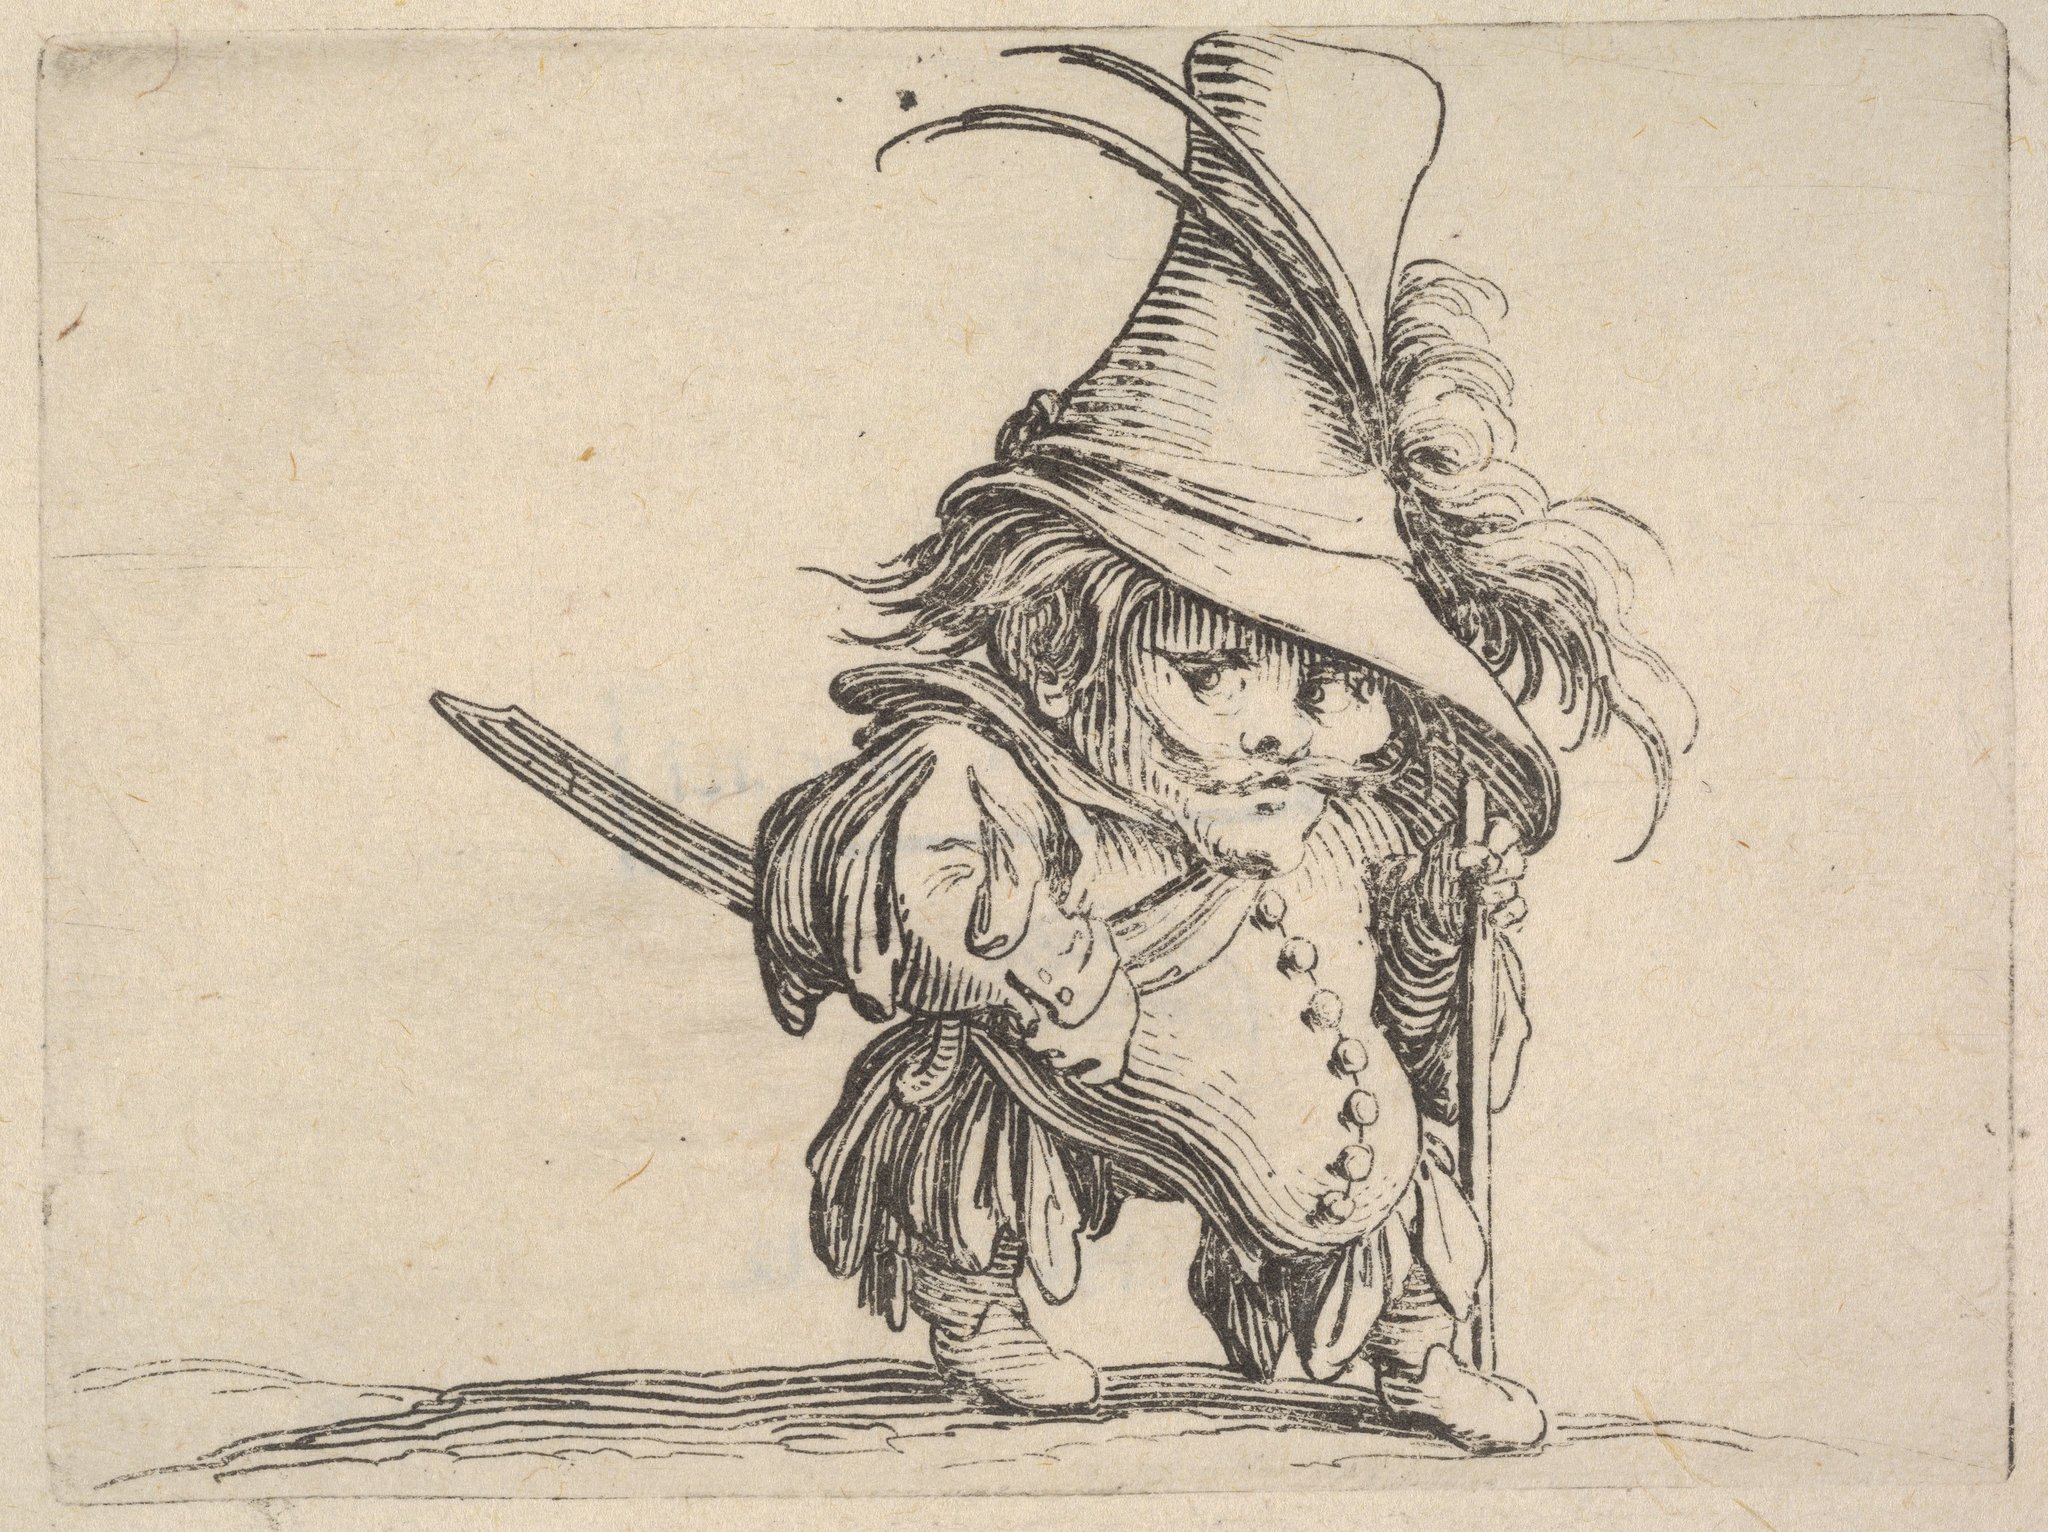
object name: print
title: Small male figure in feathered hat with walking stick in left hand, from "Varie Figure Gobbi"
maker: jacques callot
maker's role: artist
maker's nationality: french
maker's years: 1592-1635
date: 1621-1625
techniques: etching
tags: hats,men